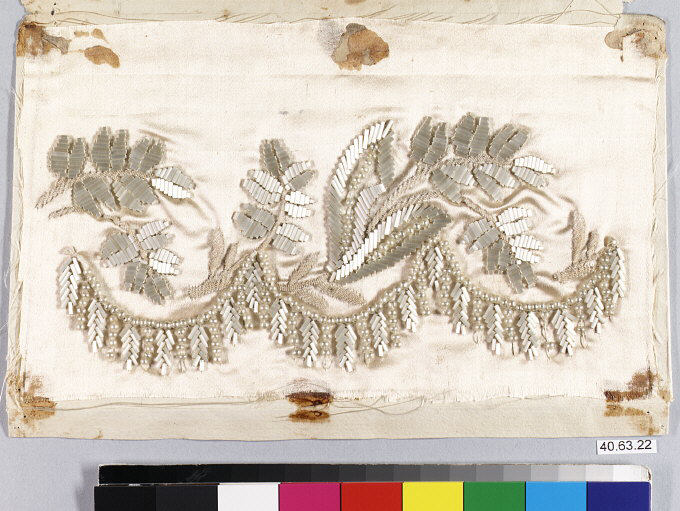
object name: border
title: Dress border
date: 1801-1833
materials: silk